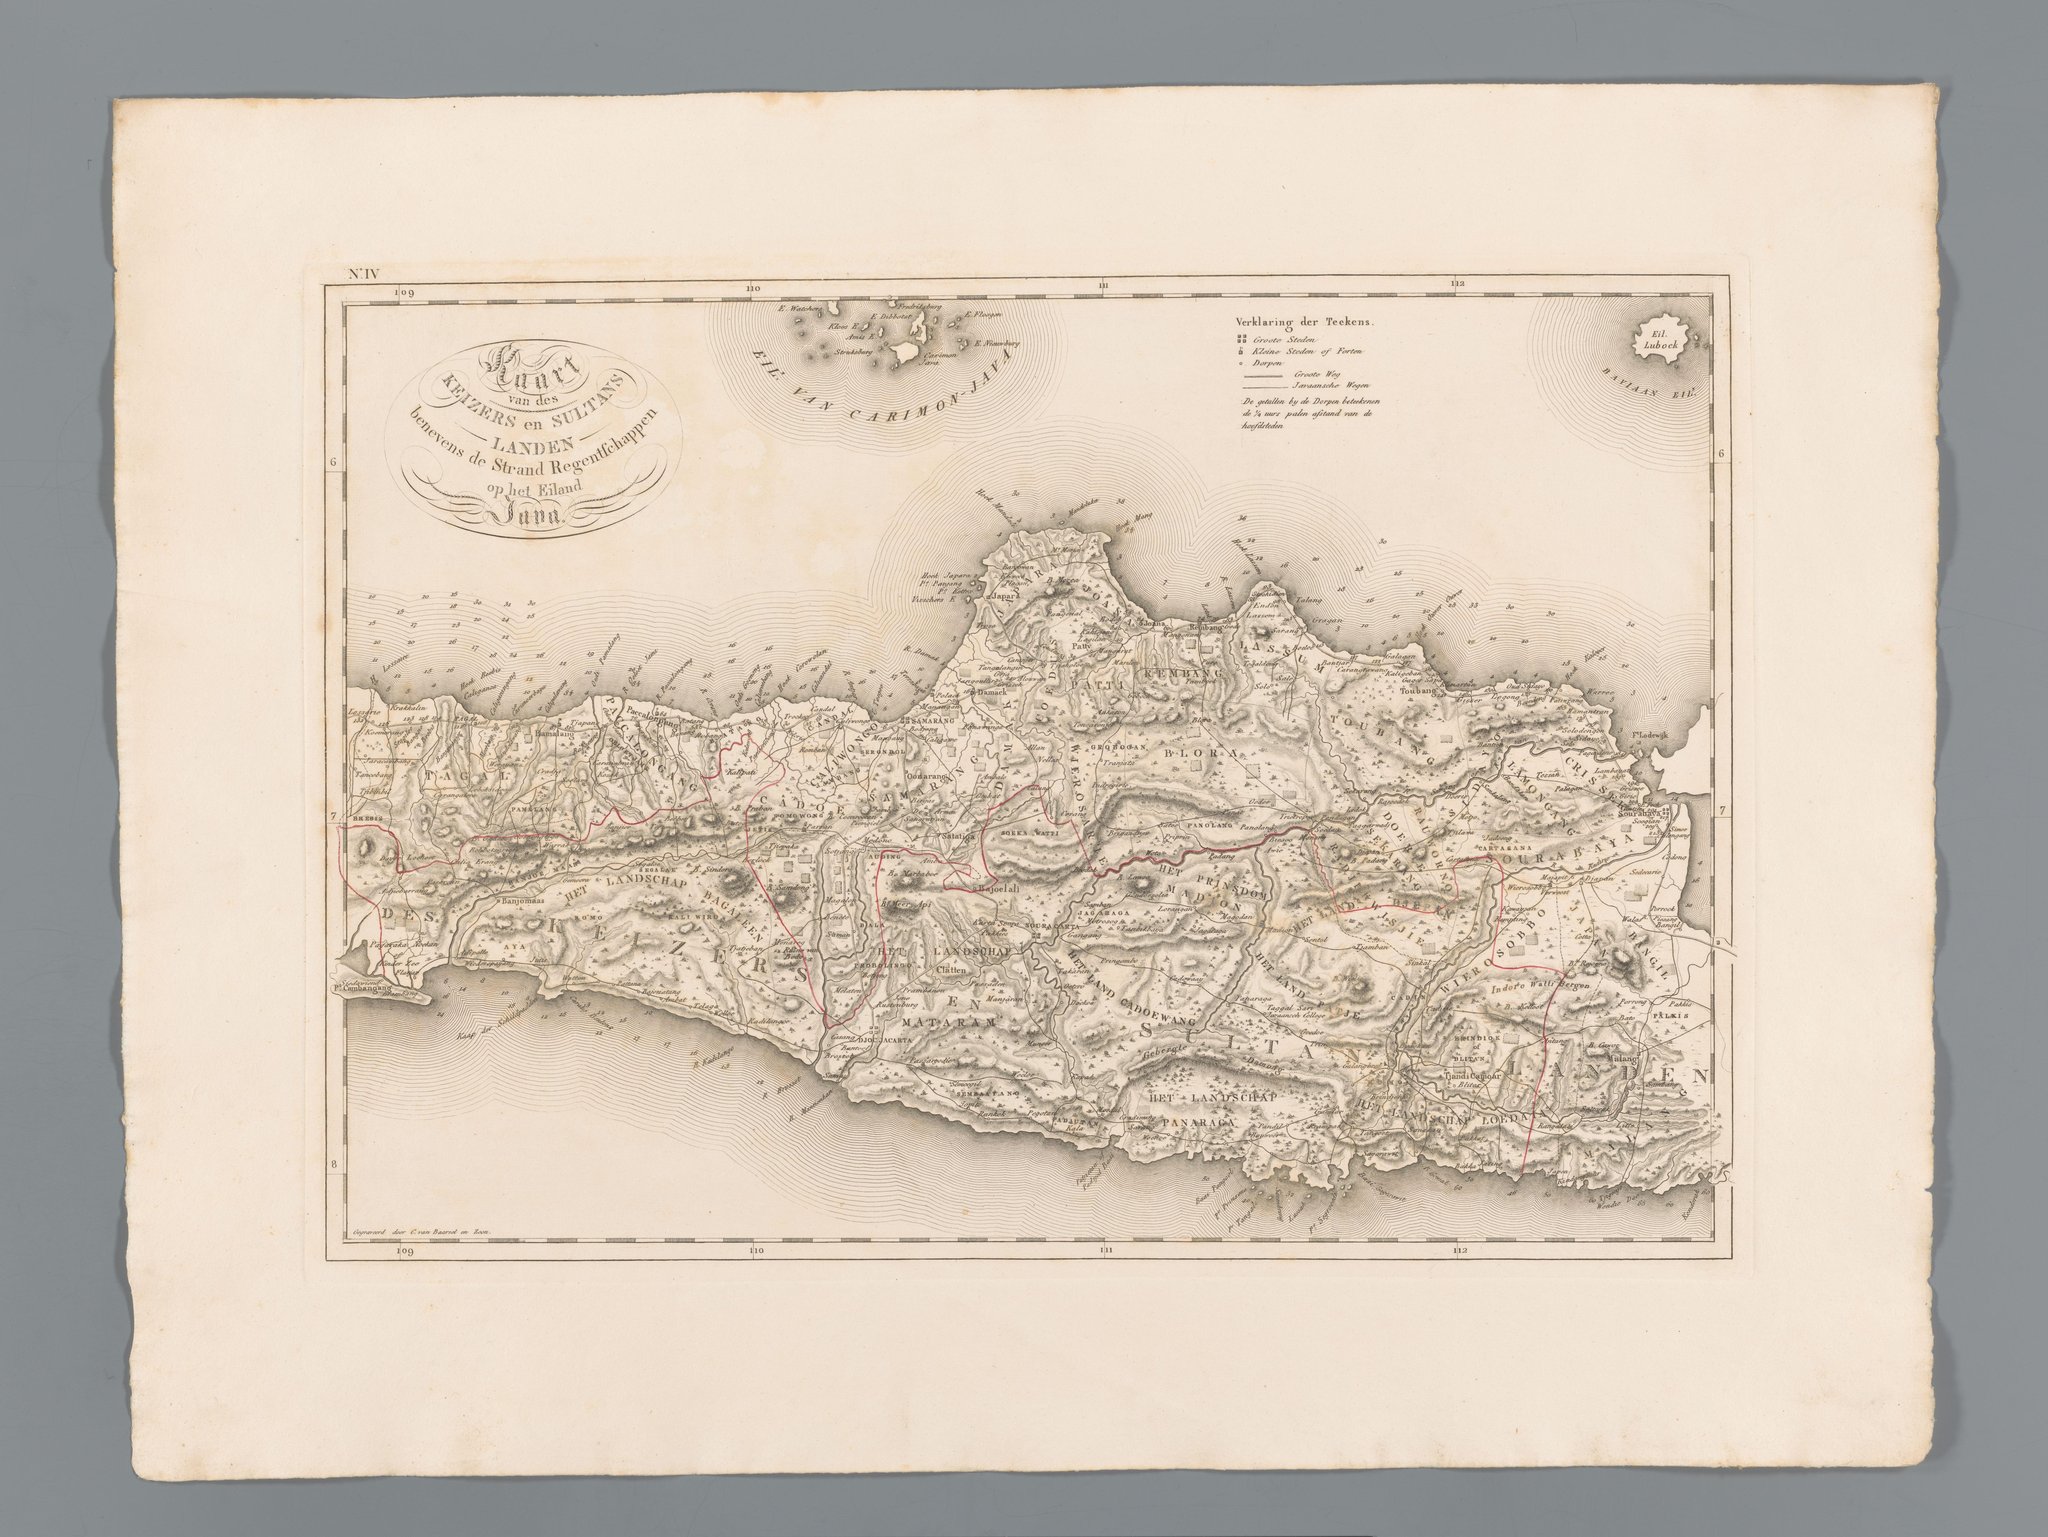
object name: print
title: Kaart van des keizers en sultans landen benevens de strand regentschappen op het eiland Java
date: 1818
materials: paper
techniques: engraving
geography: the hague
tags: maps of separate countries or regions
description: Kaart uit: Bosch, Js. van den. Atlas der overzeesche bezittingen van Zijne Majesteit den Koning der Nederlanden, aan hoogst denzelven opgedragen. Den Haag en Amsterdam: Gebroeders van Cleef, 1818.